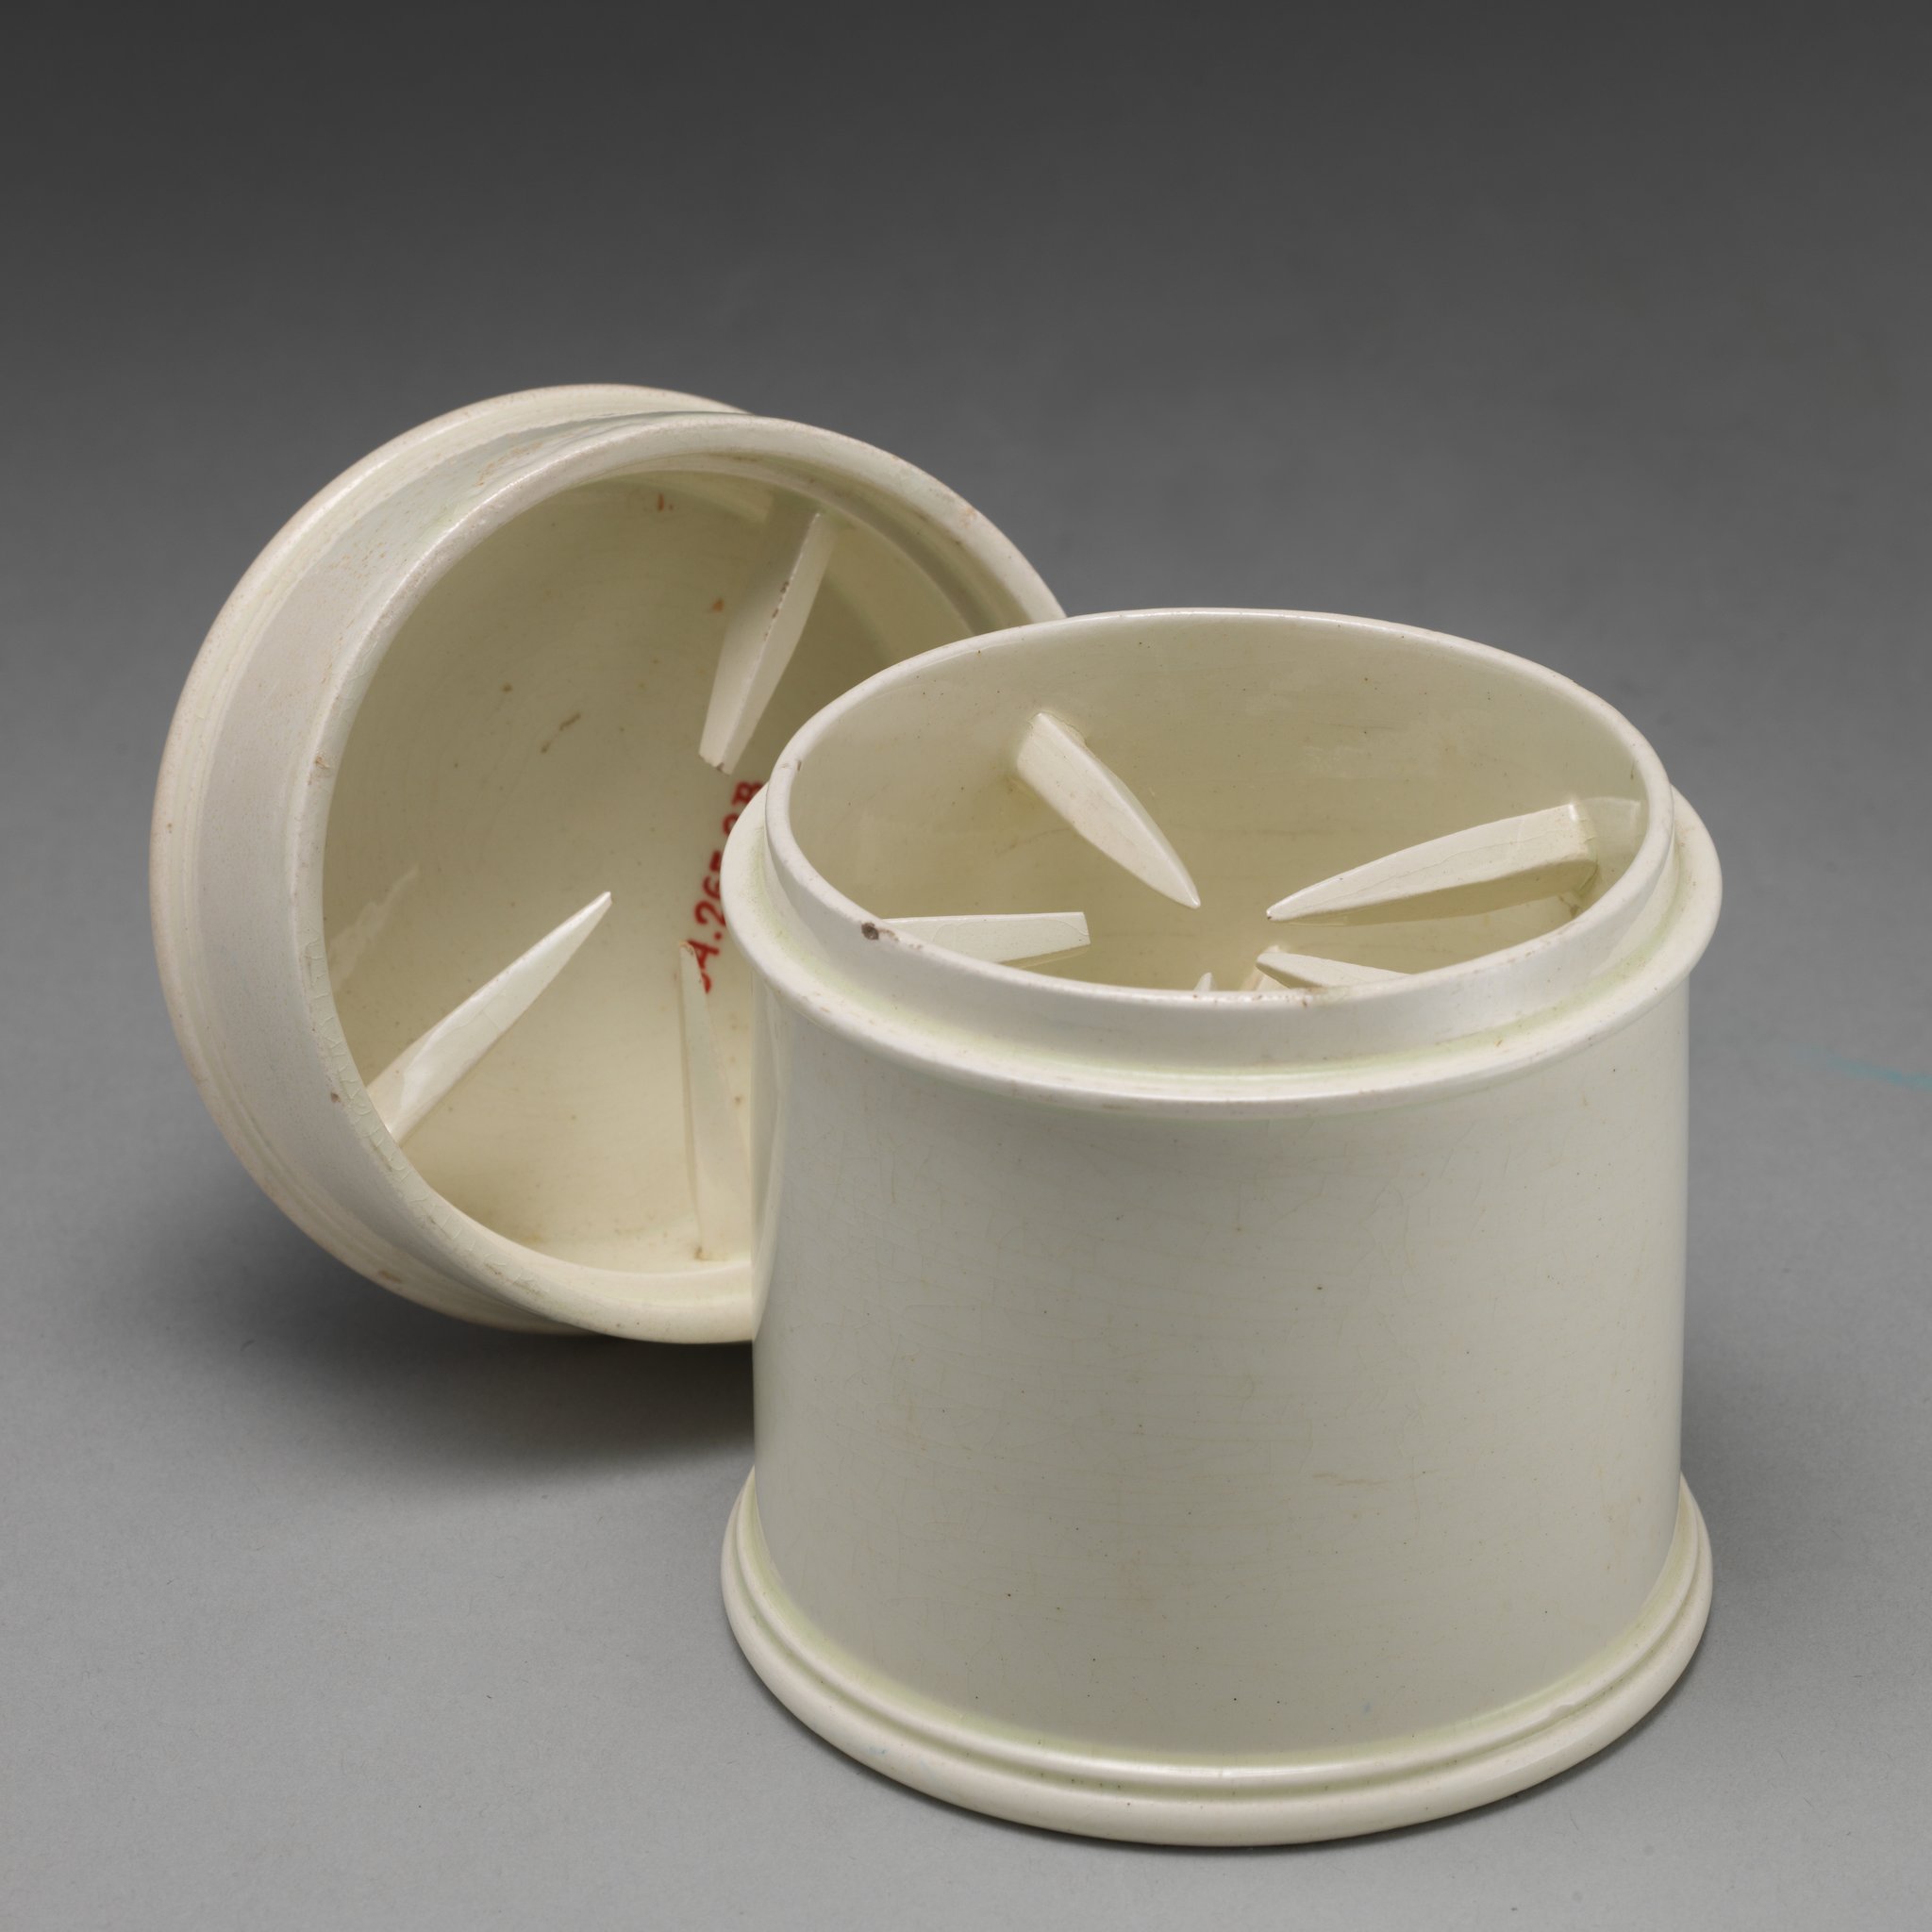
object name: egg beating box with lid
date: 1775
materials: creamware